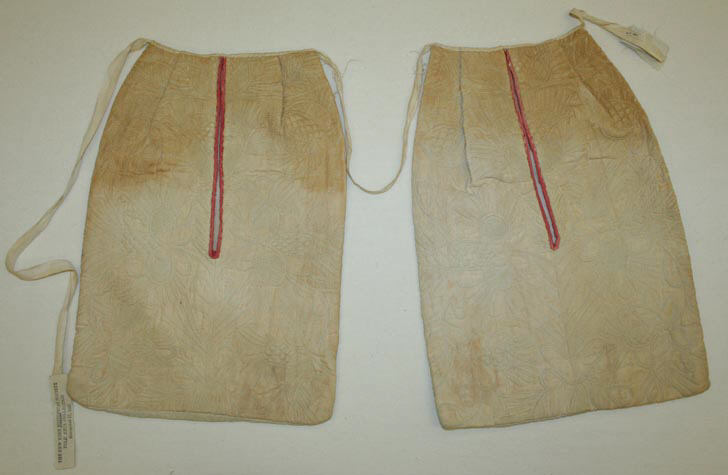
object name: pocket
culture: american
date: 1701-1800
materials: linen